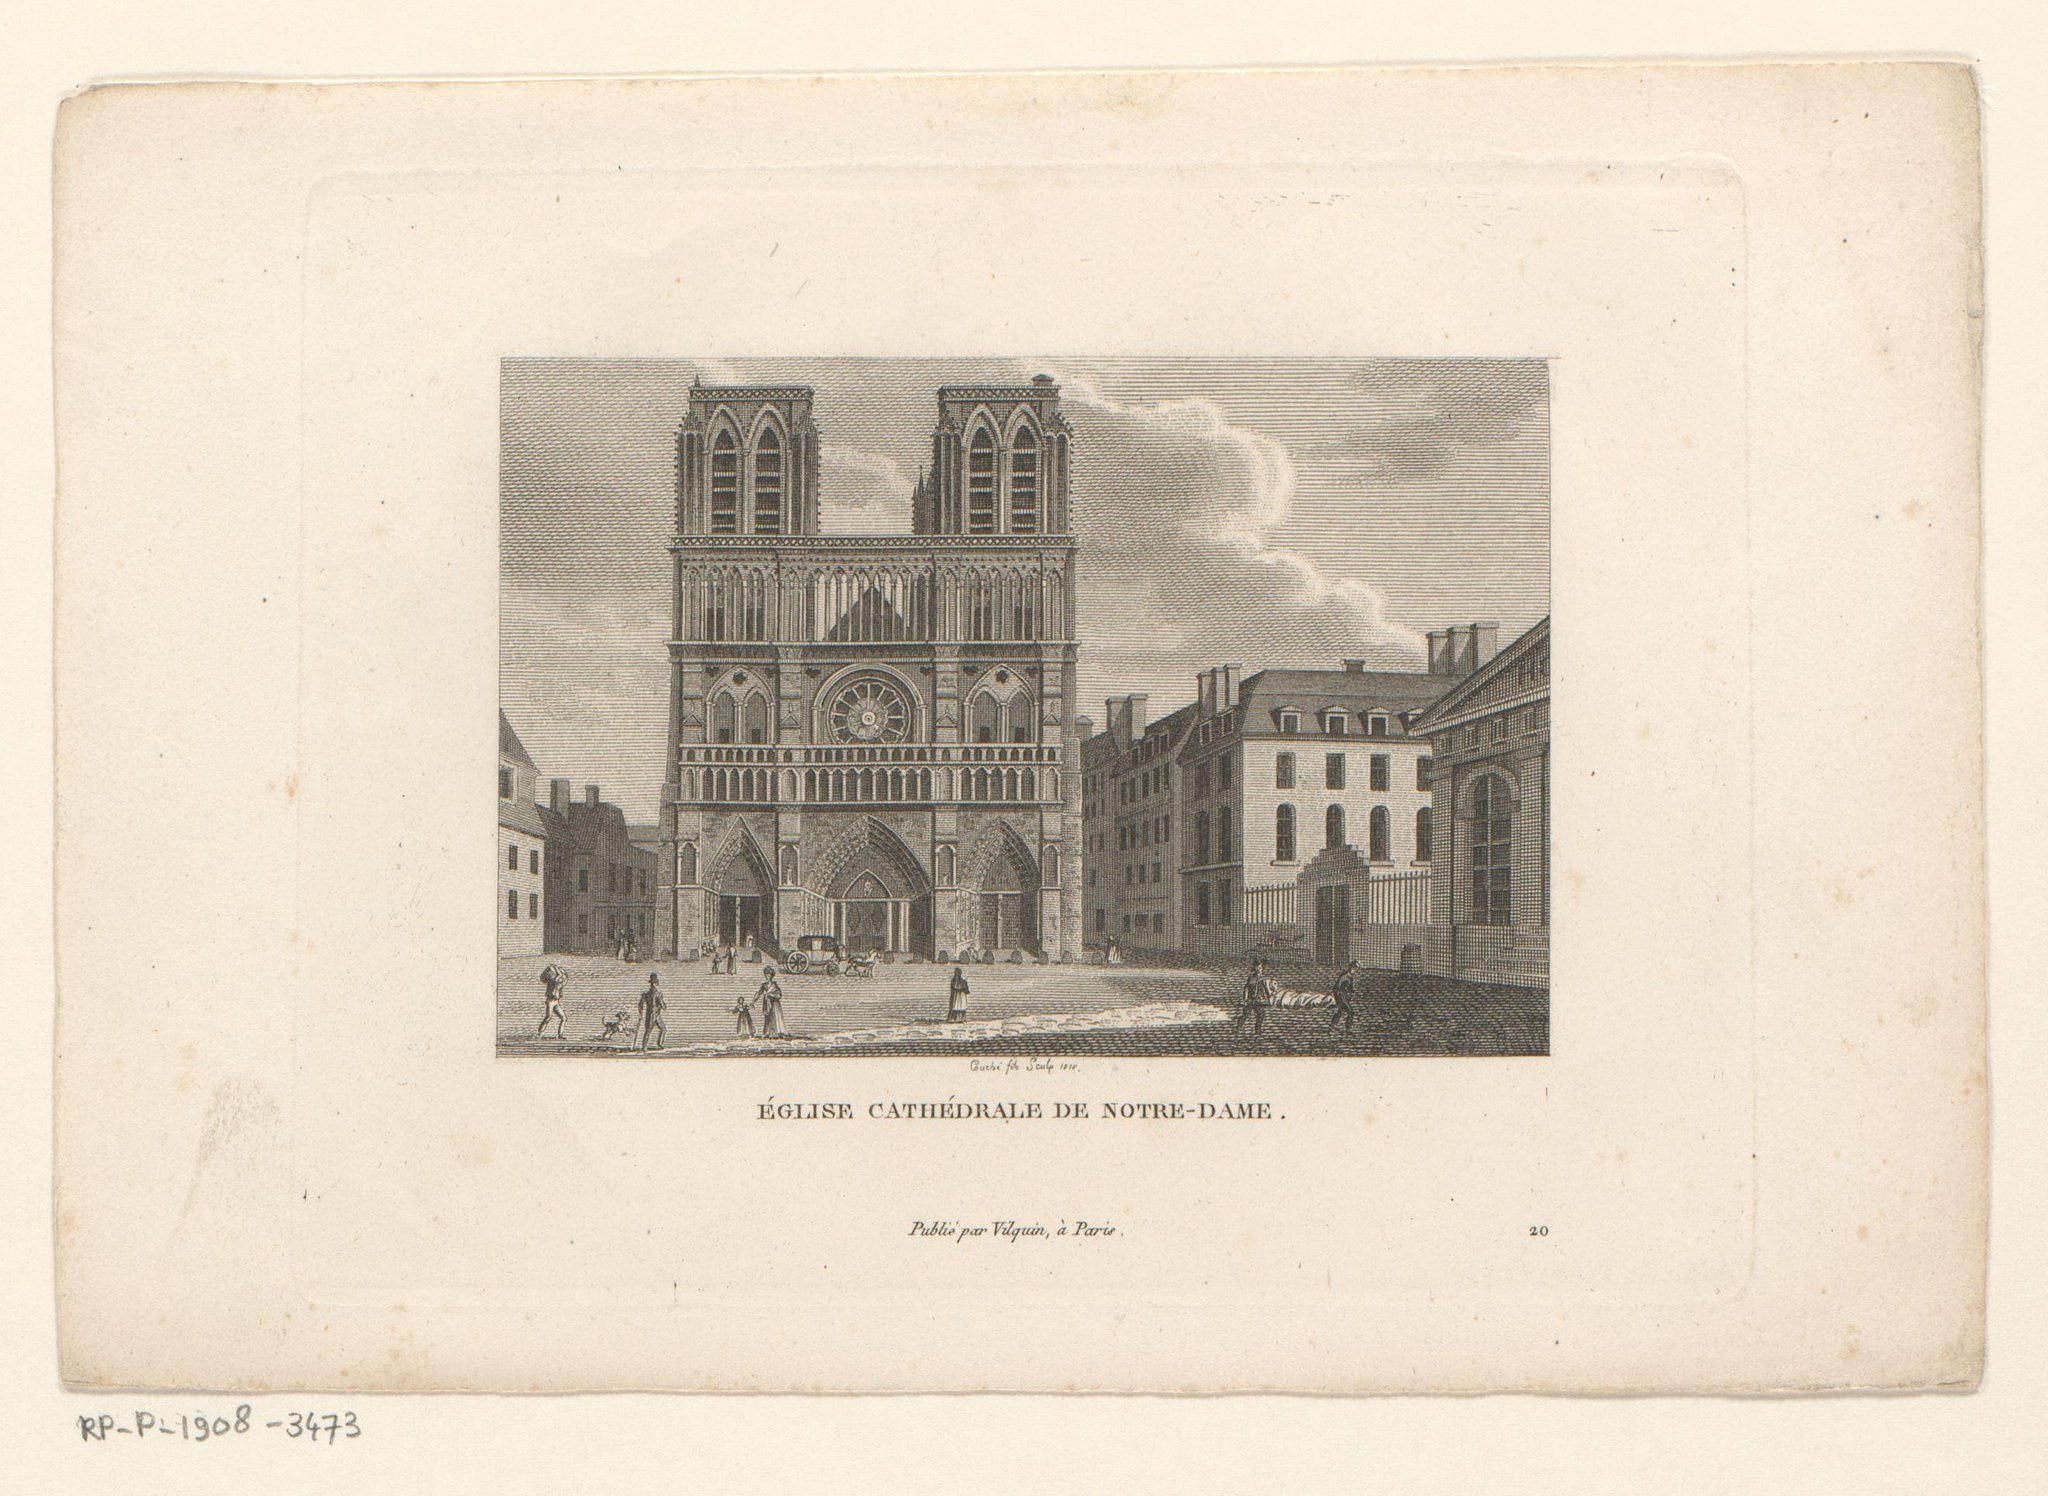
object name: print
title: Gezicht op de Notre-Dame van Parijs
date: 1818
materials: paper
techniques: etching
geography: paris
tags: city-view in general; 'veduta', paris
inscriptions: collector's mark: Lugt 2228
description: Maakt deel uit van een serie met 60 platen van monumenten, kathedralen en paleizen in Parijs.